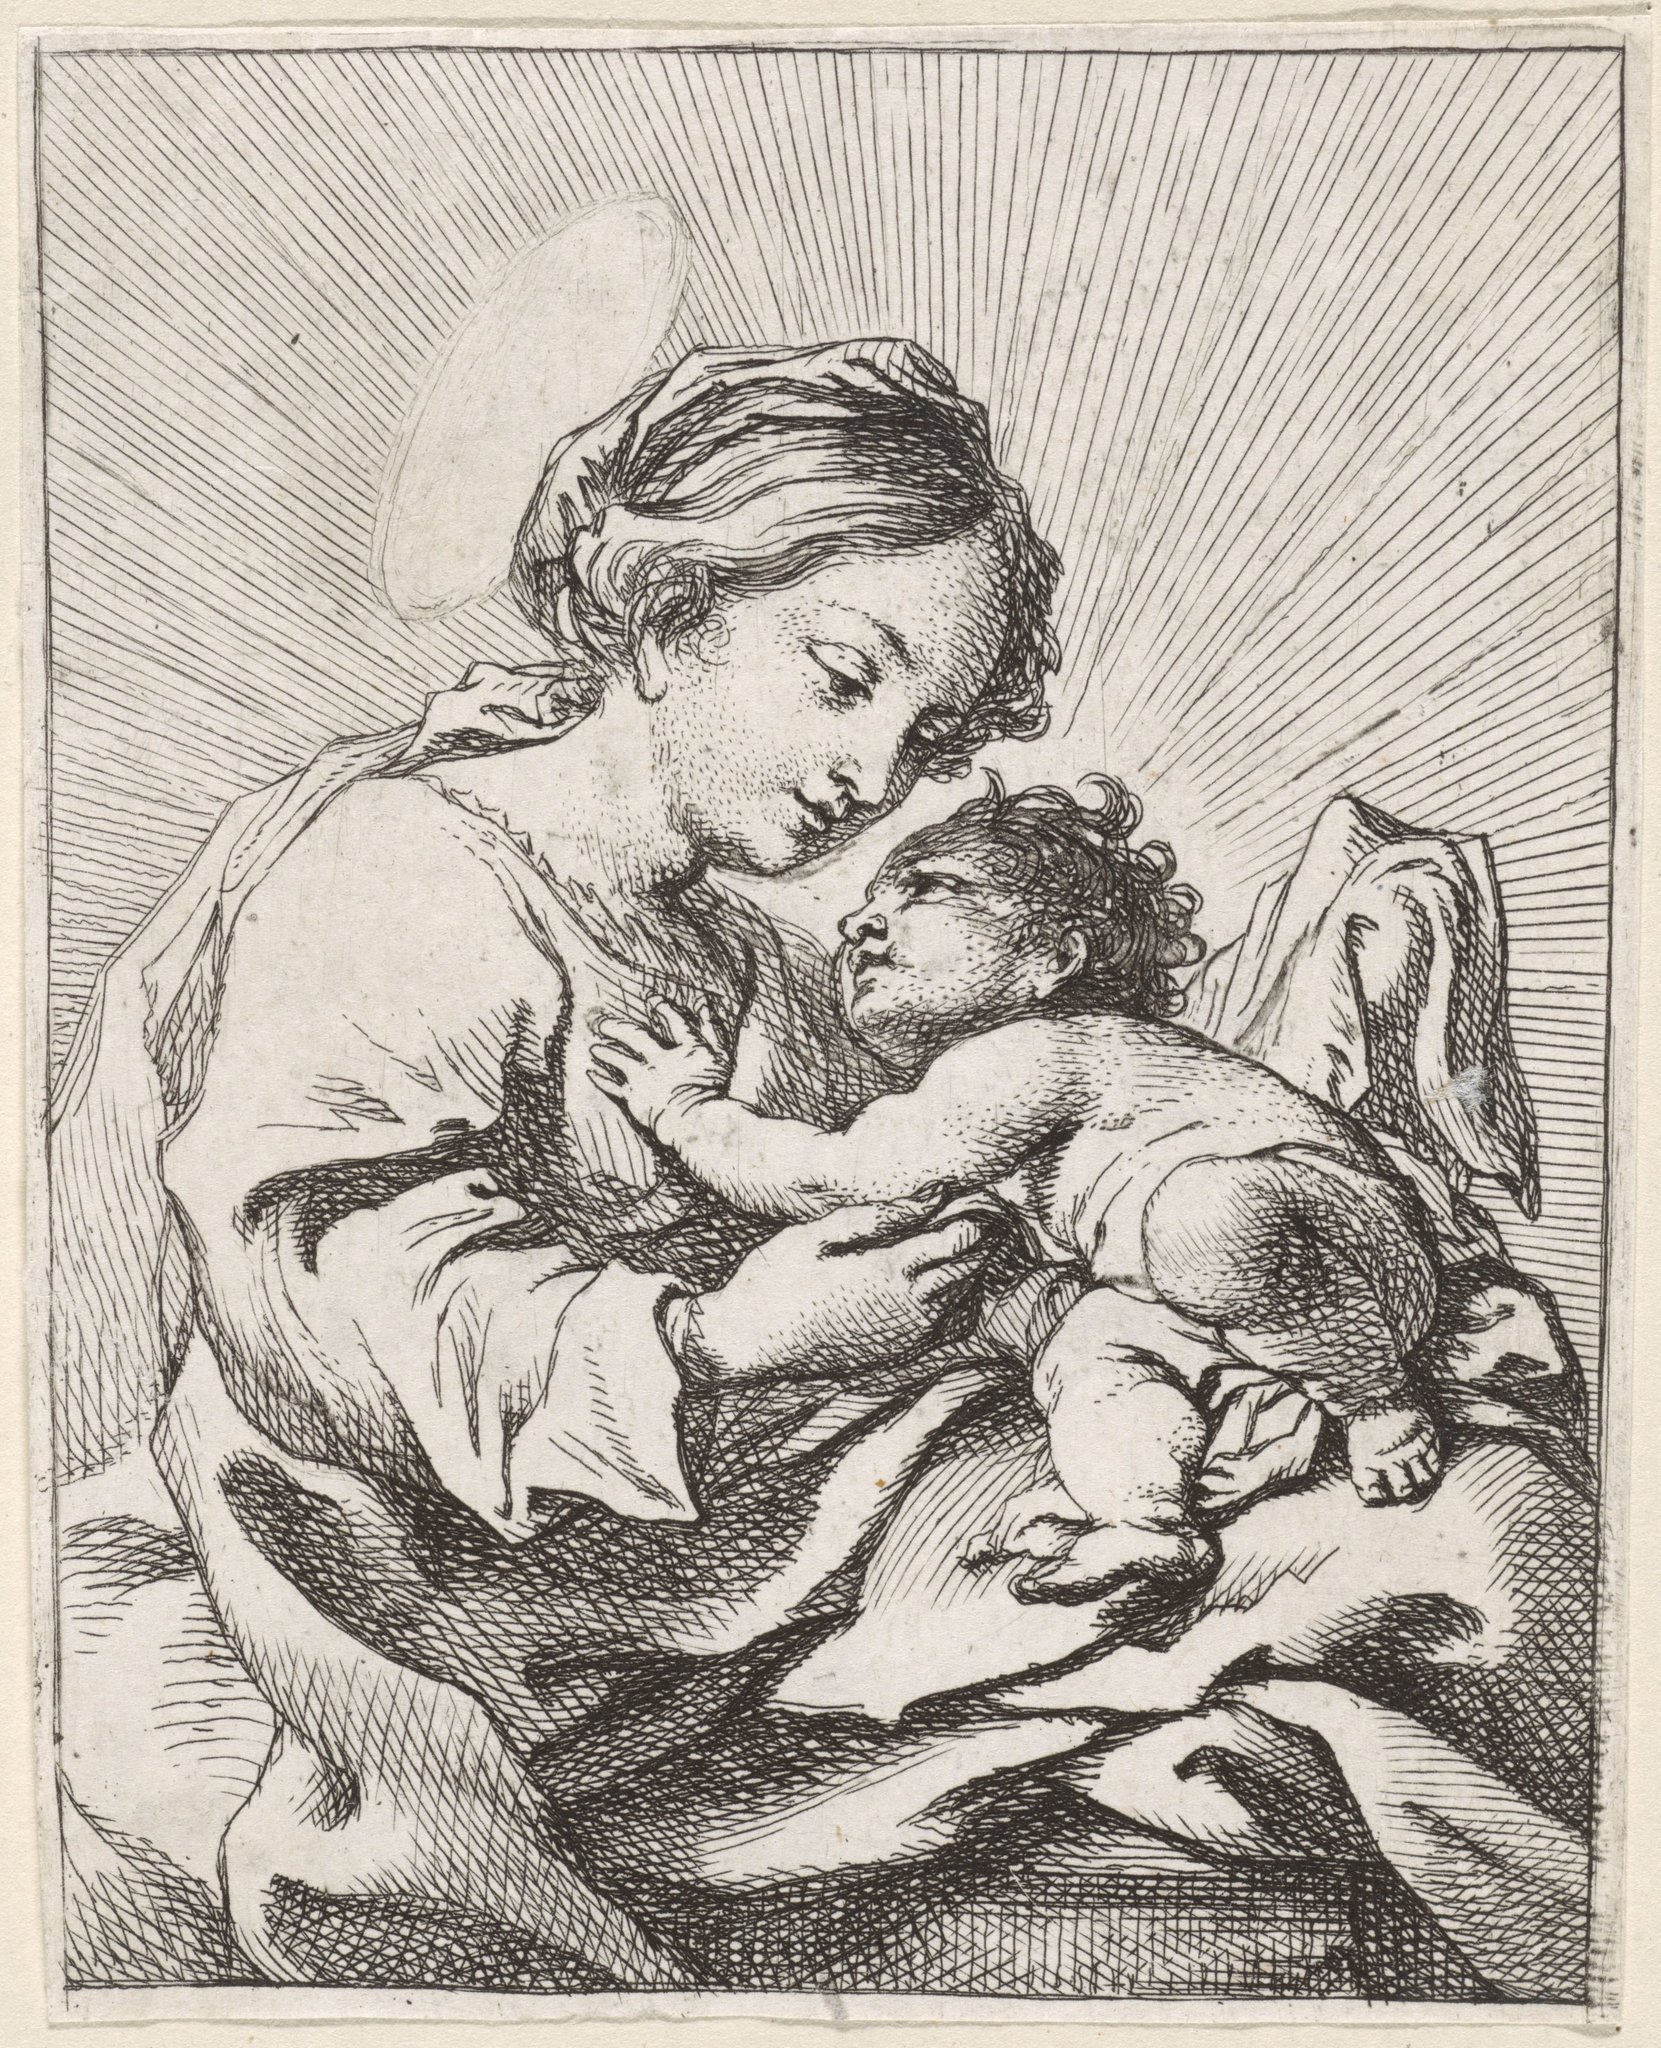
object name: print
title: Madonna met kind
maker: cornelis schut (i)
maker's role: draughtsman, print maker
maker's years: 1597-1655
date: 1618-1655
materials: paper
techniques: etching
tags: madonna: i.e. mary with the christ-child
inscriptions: collector's mark: Lugt 240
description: Het Christuskind ligt op schoot bij Maria; hij keert zich naar haar toe.